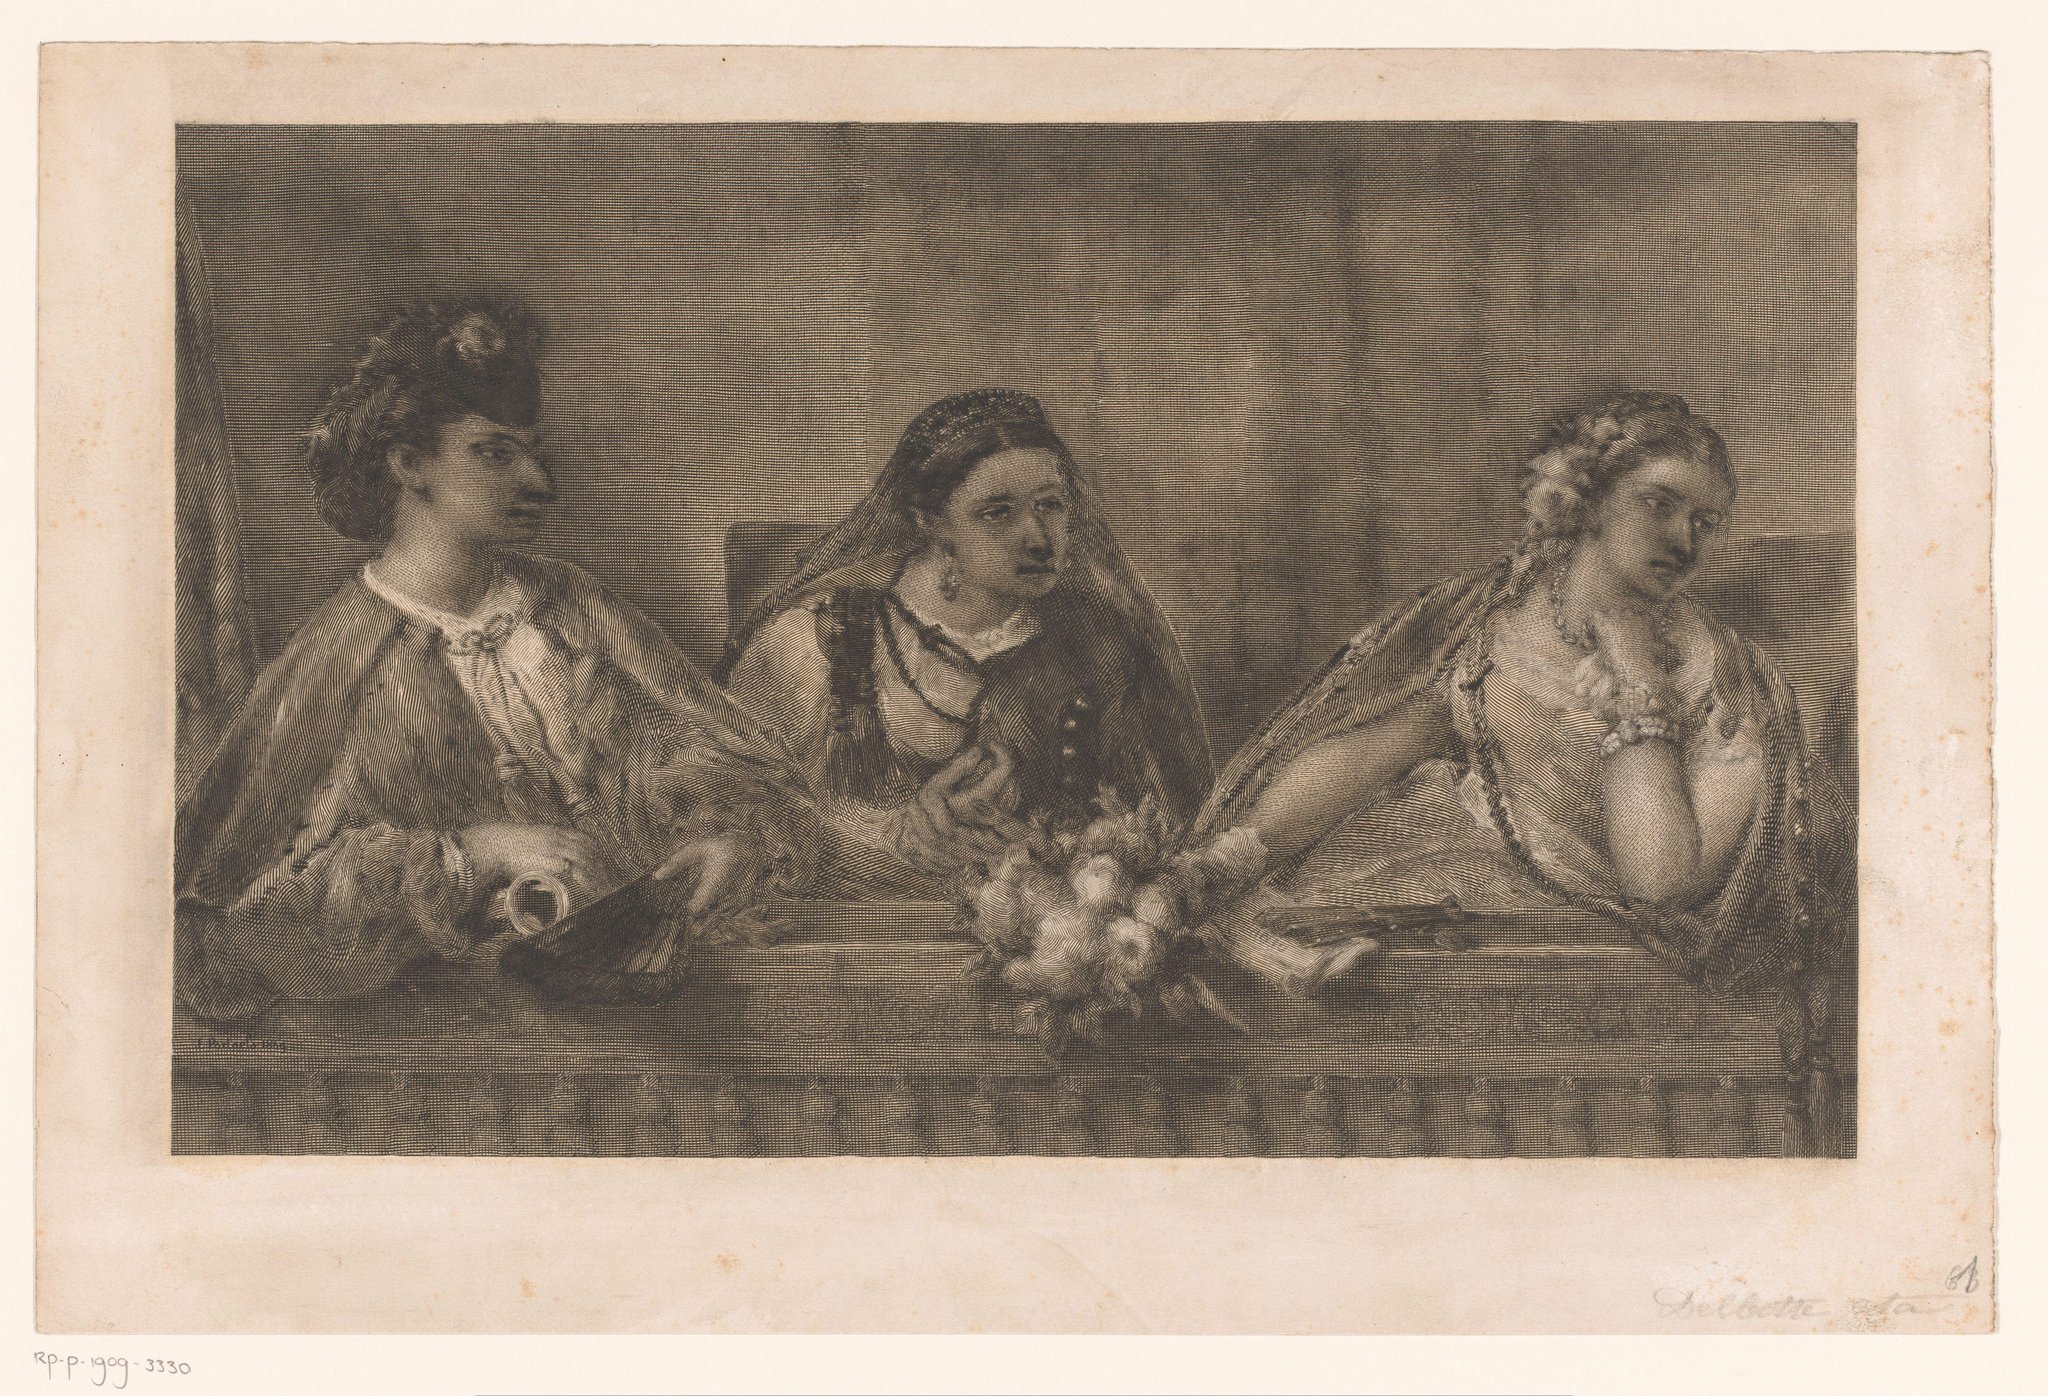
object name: print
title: Drie dames in de loge van een theater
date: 1835-1875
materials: paper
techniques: etching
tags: boxes, loges ~ theatre, etc.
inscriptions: collector's mark: Lugt 2228